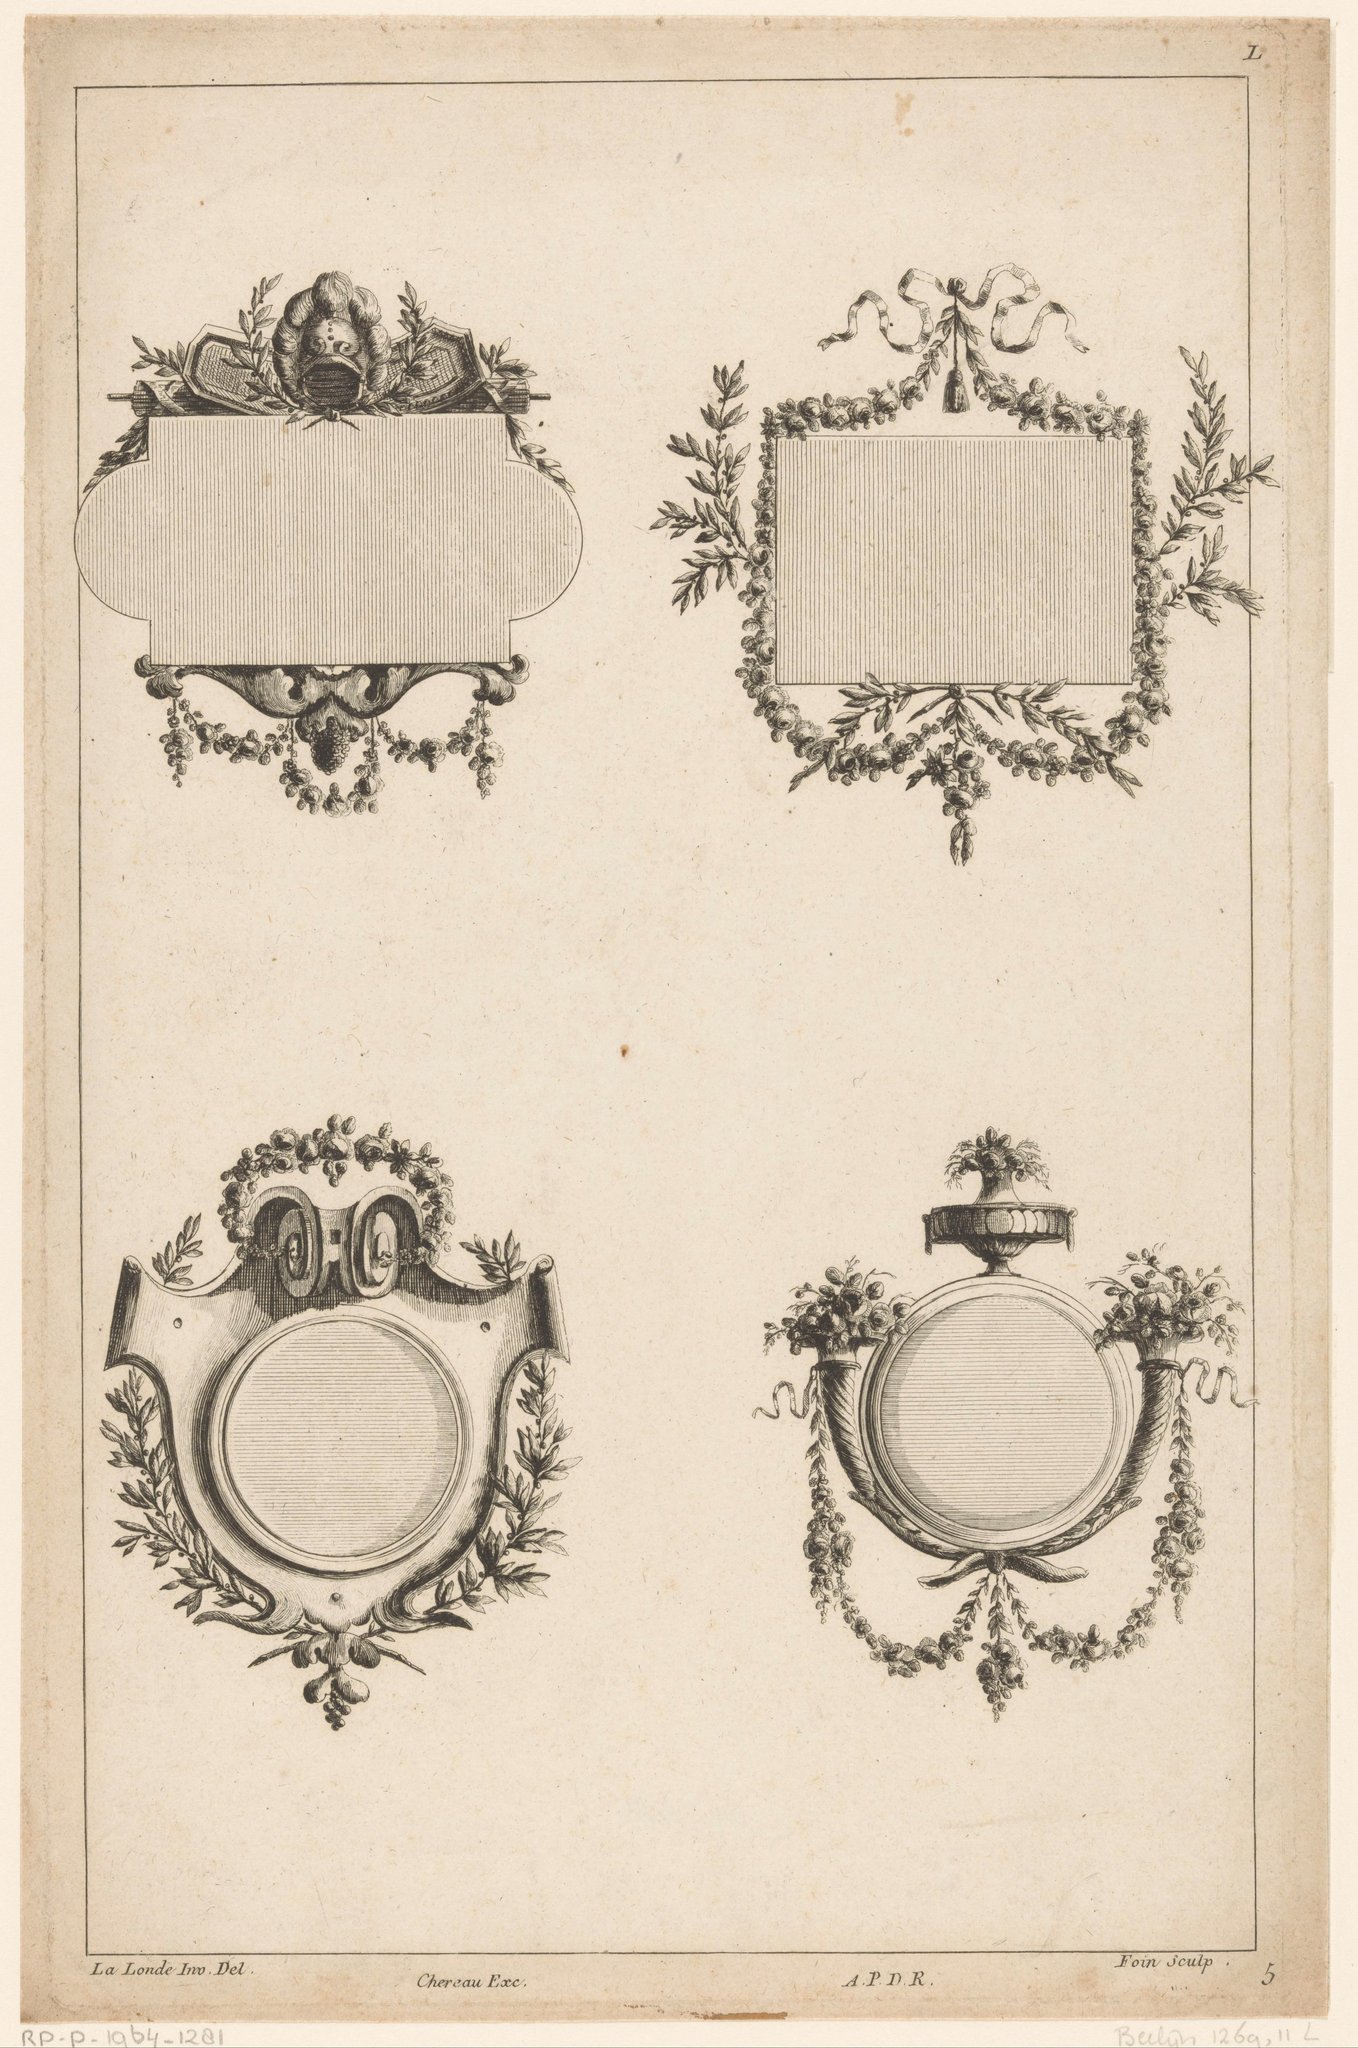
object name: print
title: L Dessus de Portes et Cartels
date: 1784-1785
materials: paper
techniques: engraving, etching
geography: paris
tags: stone tablet in façade, ornament ~ medallion, ornament ~ cartouche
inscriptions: collector's mark: Lugt 2228, collector's mark: Lugt 2760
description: Links boven een tablet met helm, schilden en guirlandes, rechts boven een tablet met guirlandes en olijventakken, links onder een rocaille cartouche met olijventakken, rechts onder een rond medaillon met vaas, hoornen des overvloeds en guirlandes.